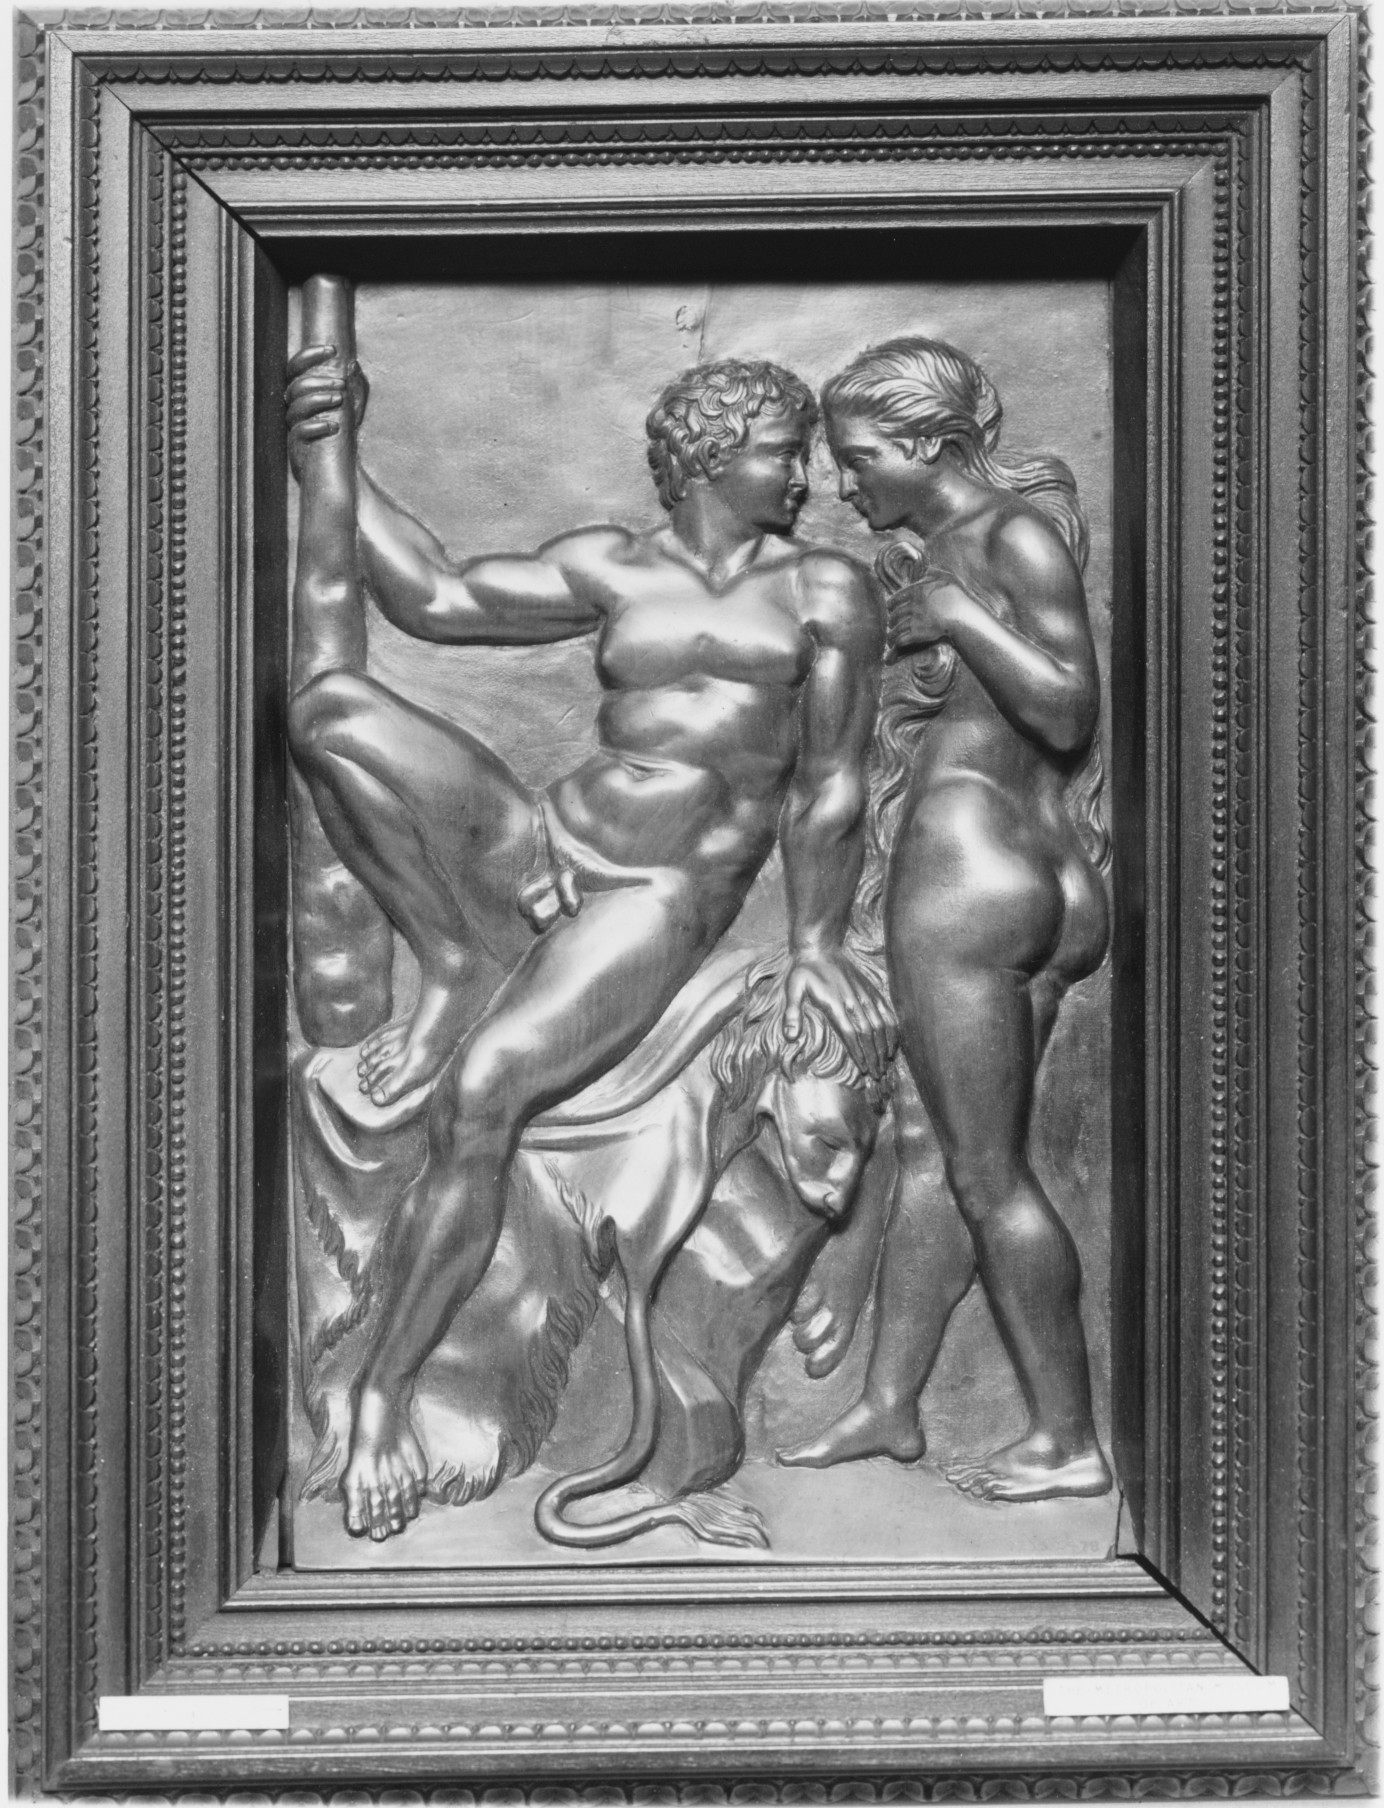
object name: high relief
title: Hercules and Omphale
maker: johann heinrich meissner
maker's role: artist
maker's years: 1725-1825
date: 1701-1800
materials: wood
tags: male nudes,female nudes,hercules